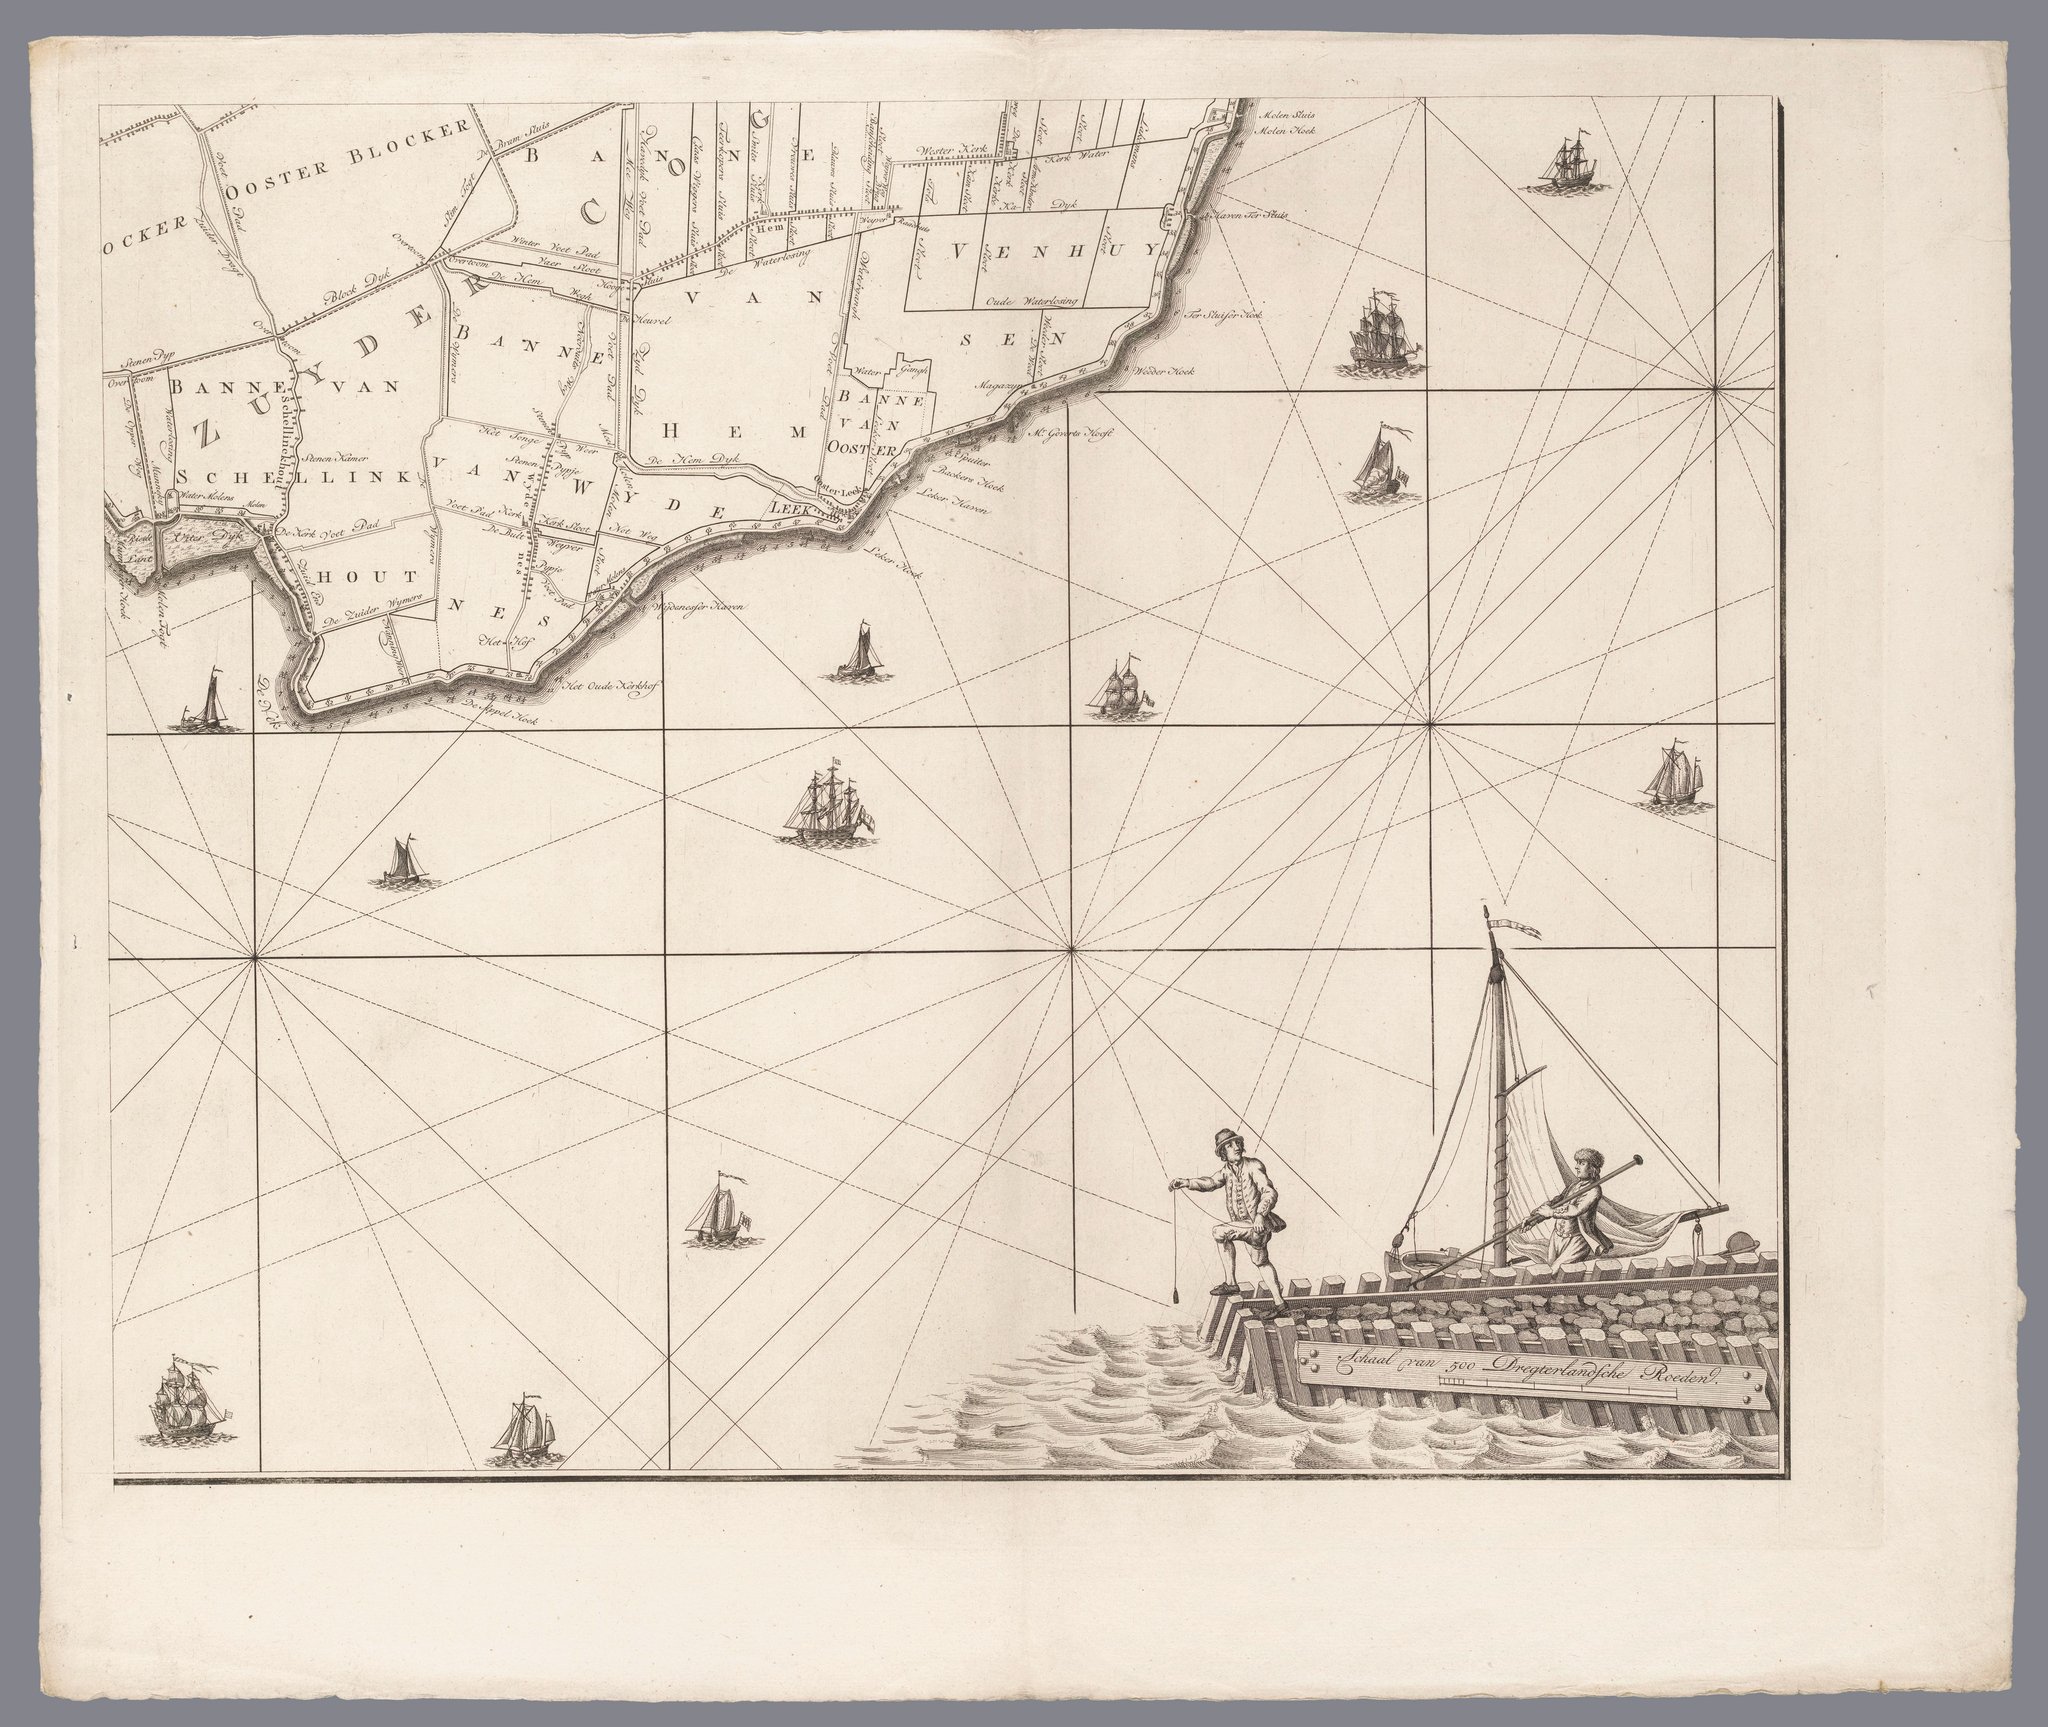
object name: map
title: Kaart van het dijkgraafschap Drechterland (deel linksonder)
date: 1775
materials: paper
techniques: engraving, etching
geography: amsterdam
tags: coat of arms (as symbol of the state, etc.) (+ city; municipal), maps of separate countries or regions, river-gods, polder, reclaimed land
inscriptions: date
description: Deel (linksonder) van een kaart van het dijkgraafschap Drechterland.